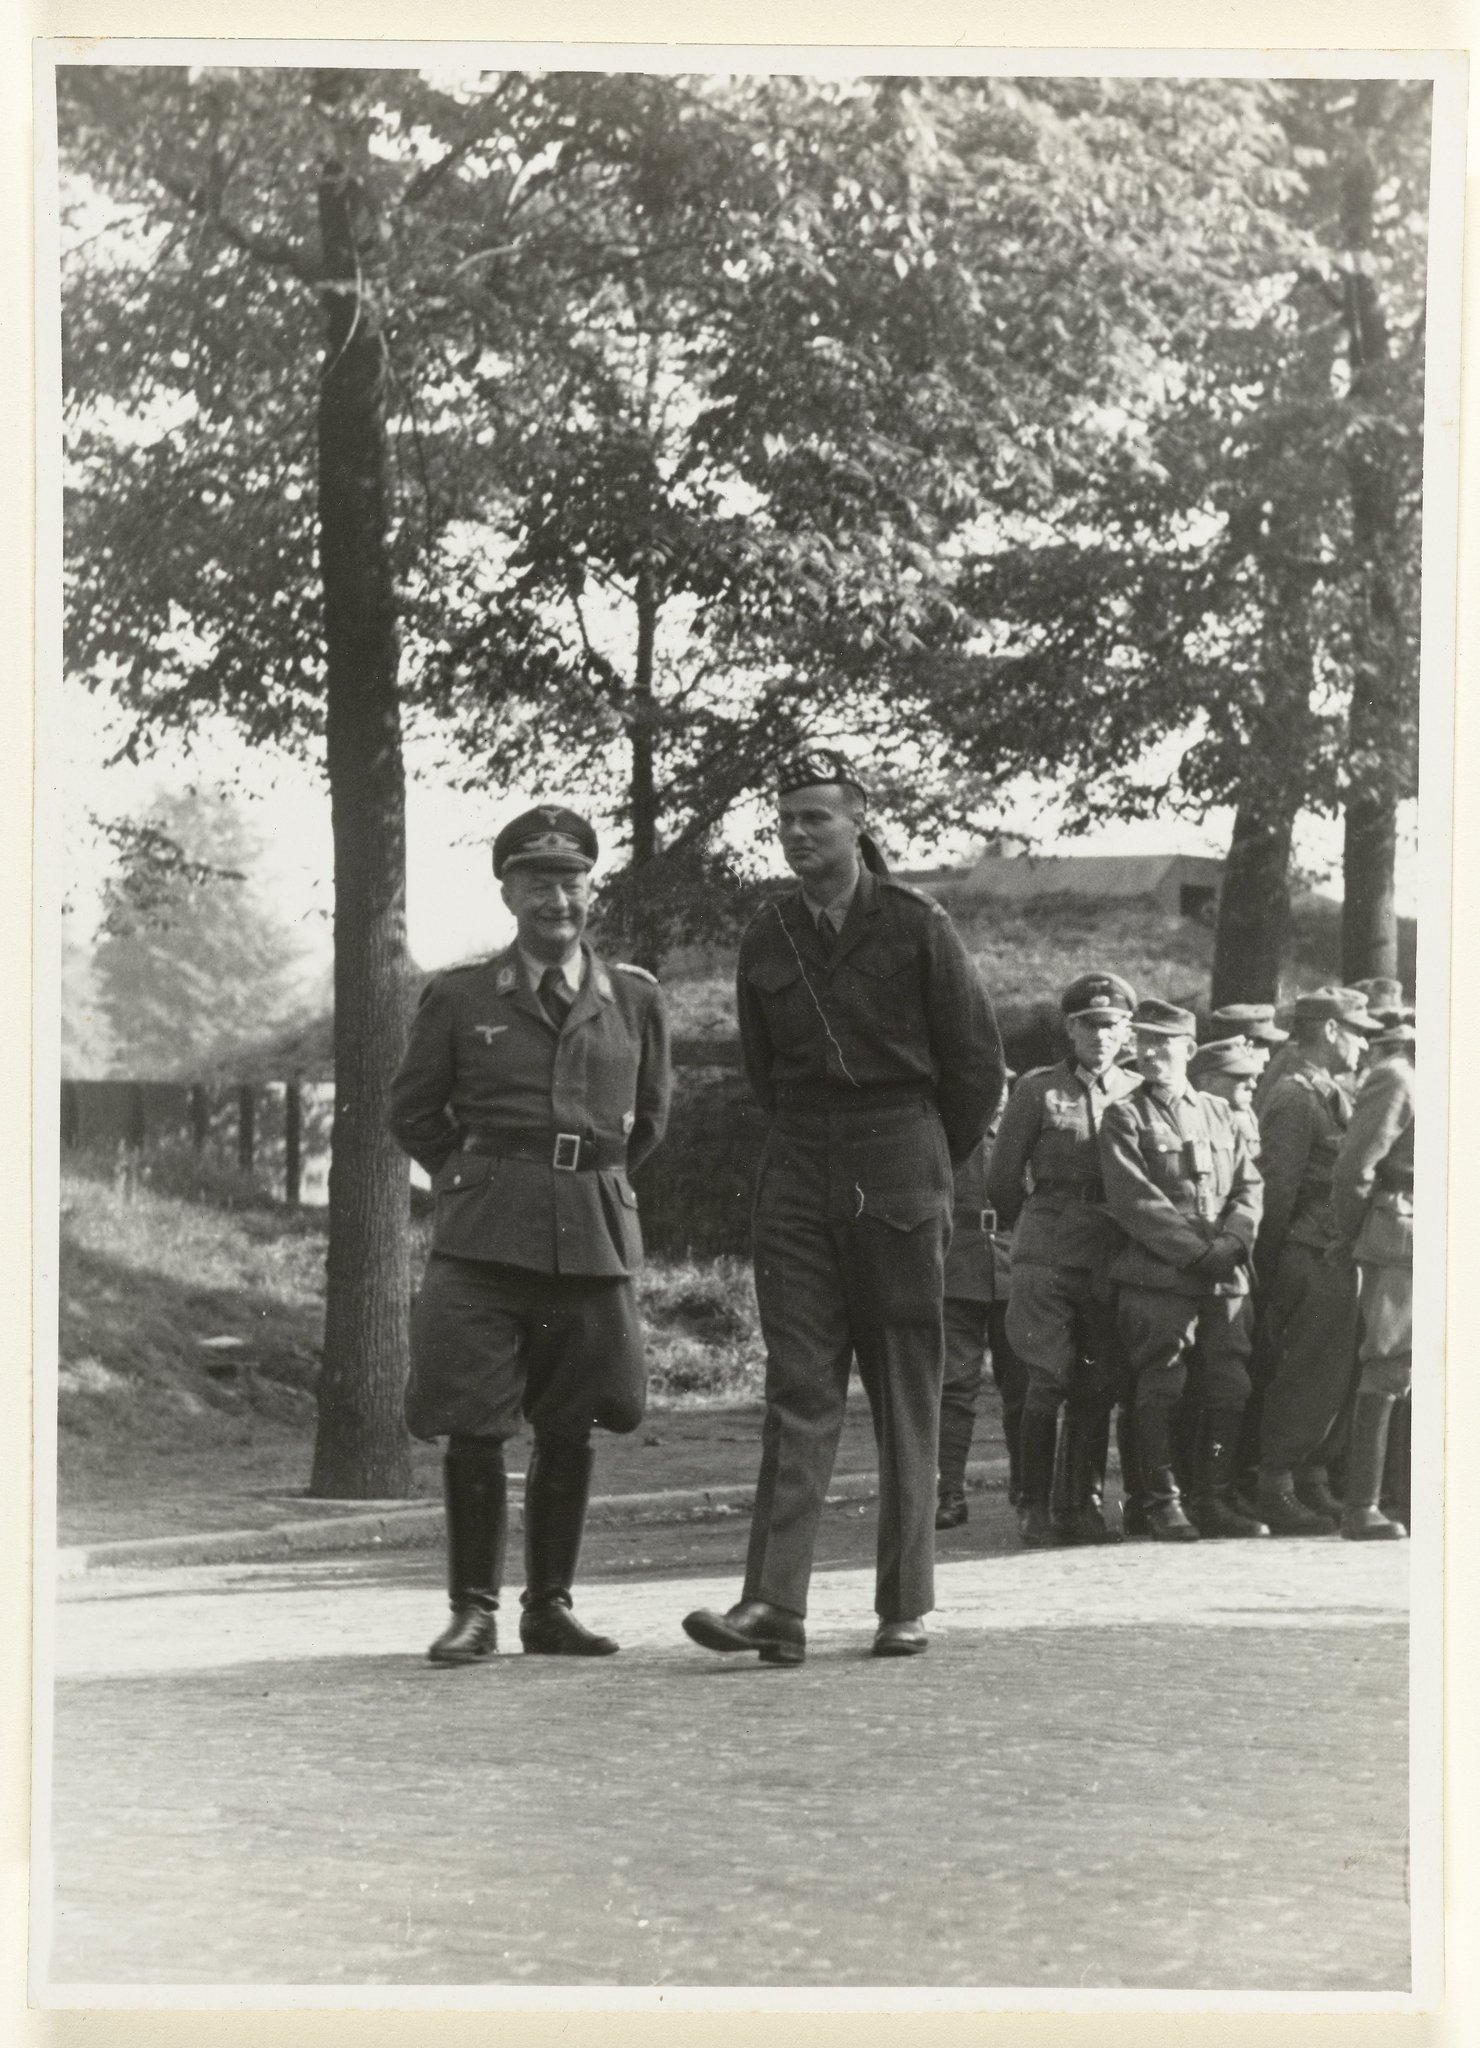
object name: photograph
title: Krijgsgevangen Duitsers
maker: Anonymous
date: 1905-1945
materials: photographic support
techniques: photography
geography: netherlands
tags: prisoner of war (after the battle), netherlands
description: Duitse krijgsgevangenen bewaakt door Engelse? militairen. Links hoge Luftwaffe officier, naast hem militair van de geallieerden. Op de achtergrond krijgsgevangenen.